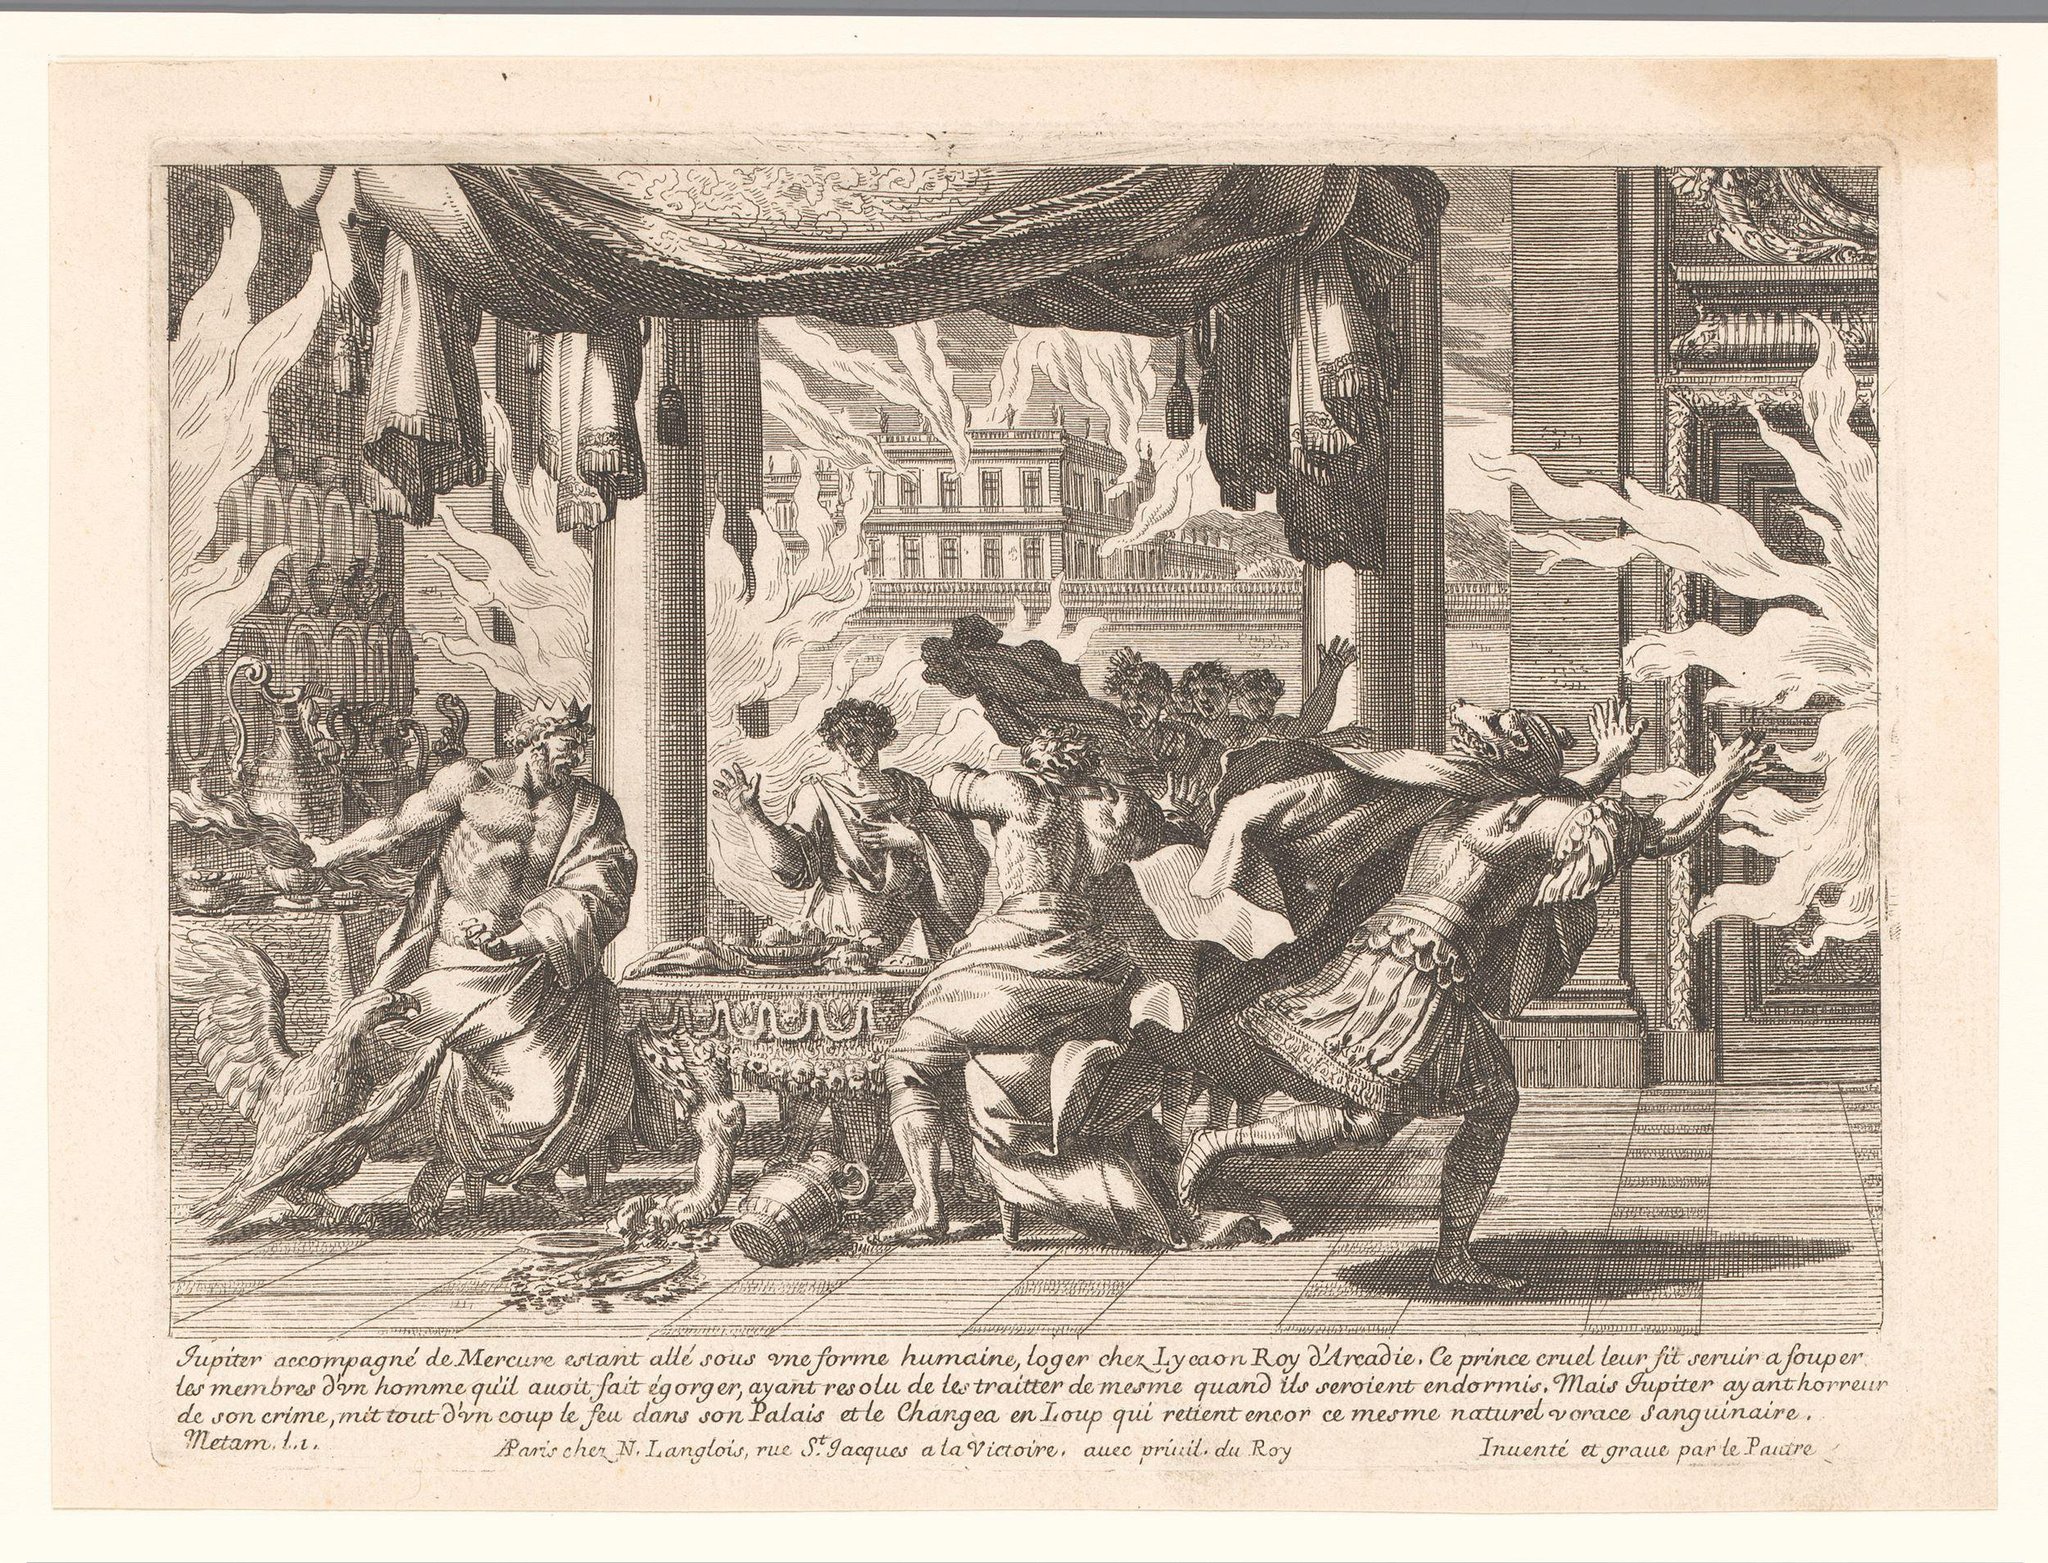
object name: print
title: Jupiter verandert koning Lycaon in een wolf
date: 1650-1682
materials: paper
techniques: etching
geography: france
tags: lycaon changed into a wolf: jupiter changes lycaon into a wolf as punishment for offering the god, who is sitting at table, human flesh to eat; lycaon's house is struck with lightning (ovid, metamorphoses i 237)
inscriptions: collector's mark: Lugt 2228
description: Maakt deel uit van een zesdelige serie met scènes uit de Metamorfosen van Ovidius.